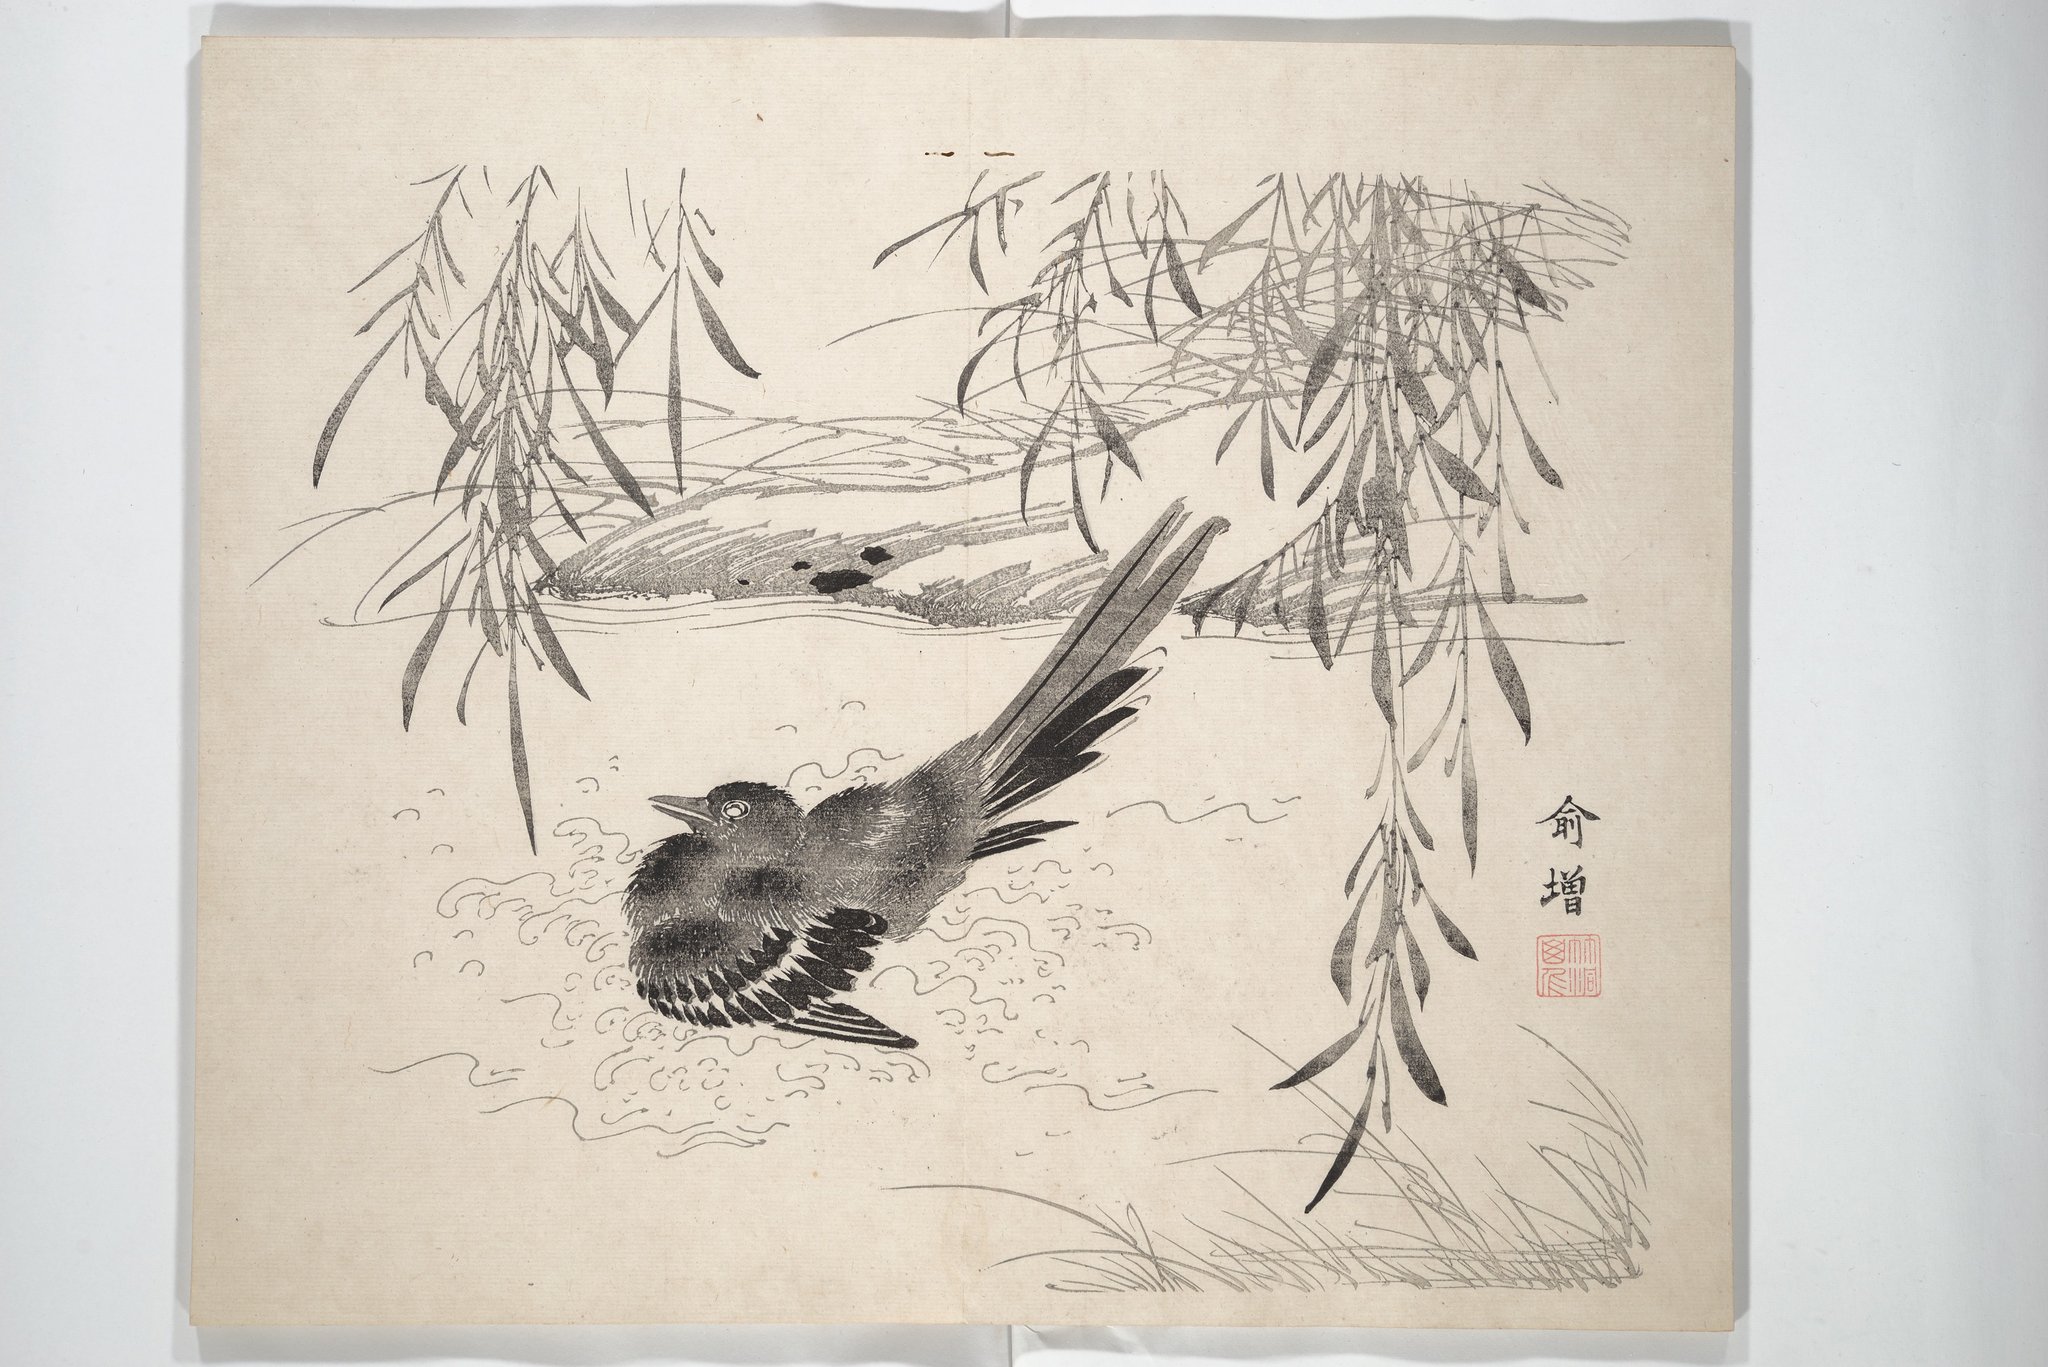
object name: illustrated book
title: Yūsai Picture Album (Yūsai gafu) 融齋畫譜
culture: japanese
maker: nakabayashi chikutō 中林竹洞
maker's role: artist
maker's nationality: japanese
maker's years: 1776-1853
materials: ink, paper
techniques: woodblock print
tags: birds